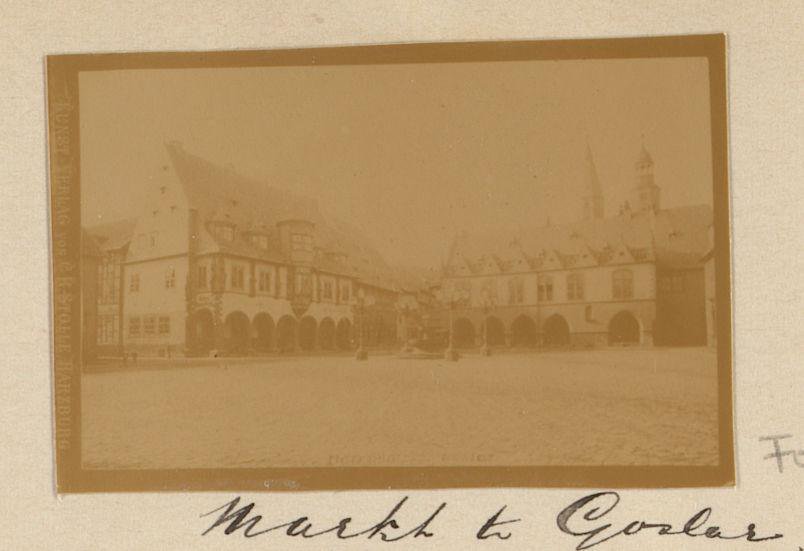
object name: photograph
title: Gezicht op het marktplein te Goslar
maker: Anonymous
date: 1885-1891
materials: photographic support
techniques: albumen print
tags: square, place, circus, etc.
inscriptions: annotation: ‘Markt te Goslar’, annotation: ‘Laatste dag in/ de Harz/ (...)’